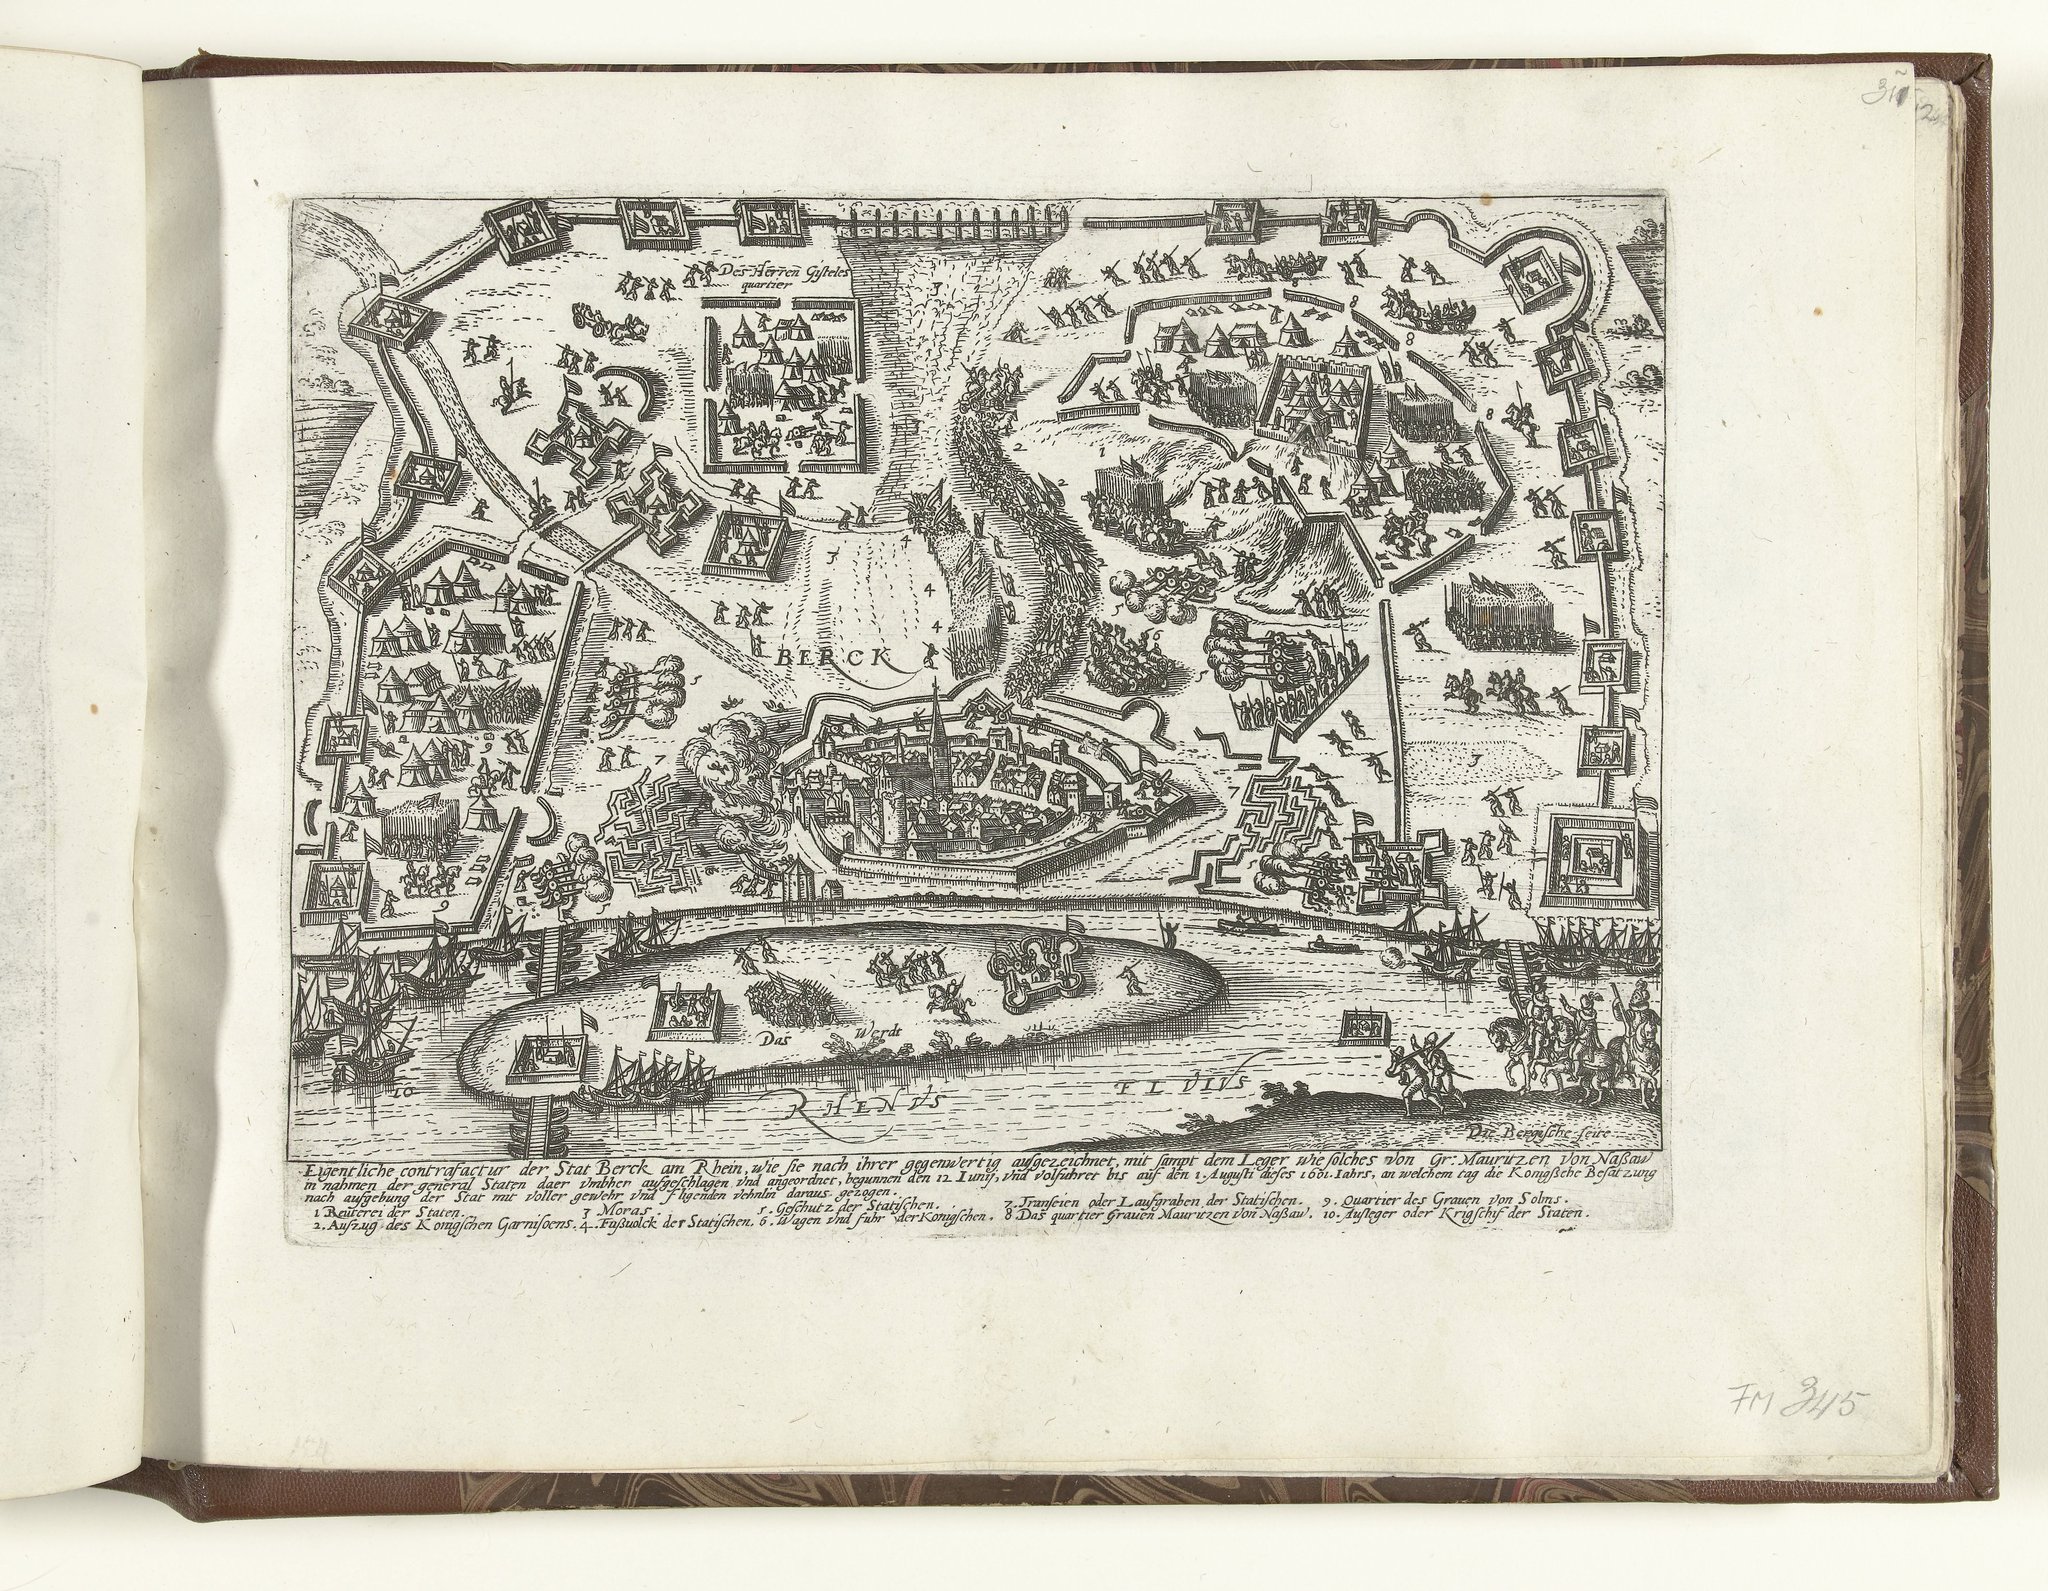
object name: print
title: Serie 10: Nederlandse en Buitenlandse Gebeurtenissen, 1587-1612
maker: frans hogenberg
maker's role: print maker, publisher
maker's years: 1538-1590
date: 1601-1603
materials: paper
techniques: etching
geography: cologne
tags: capture of city (after the siege)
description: Inname van Rheinberg door het Staatse leger onder prins Maurits en het vertrek van de Spaanse troepen, 1 augustus 1601. Plan van de stad en omgeving met de stellingen van de belegeraars. Onder de voorstelling de titel en de legenda van de cijfers 1-10, in het Duits. Ongenummerd.